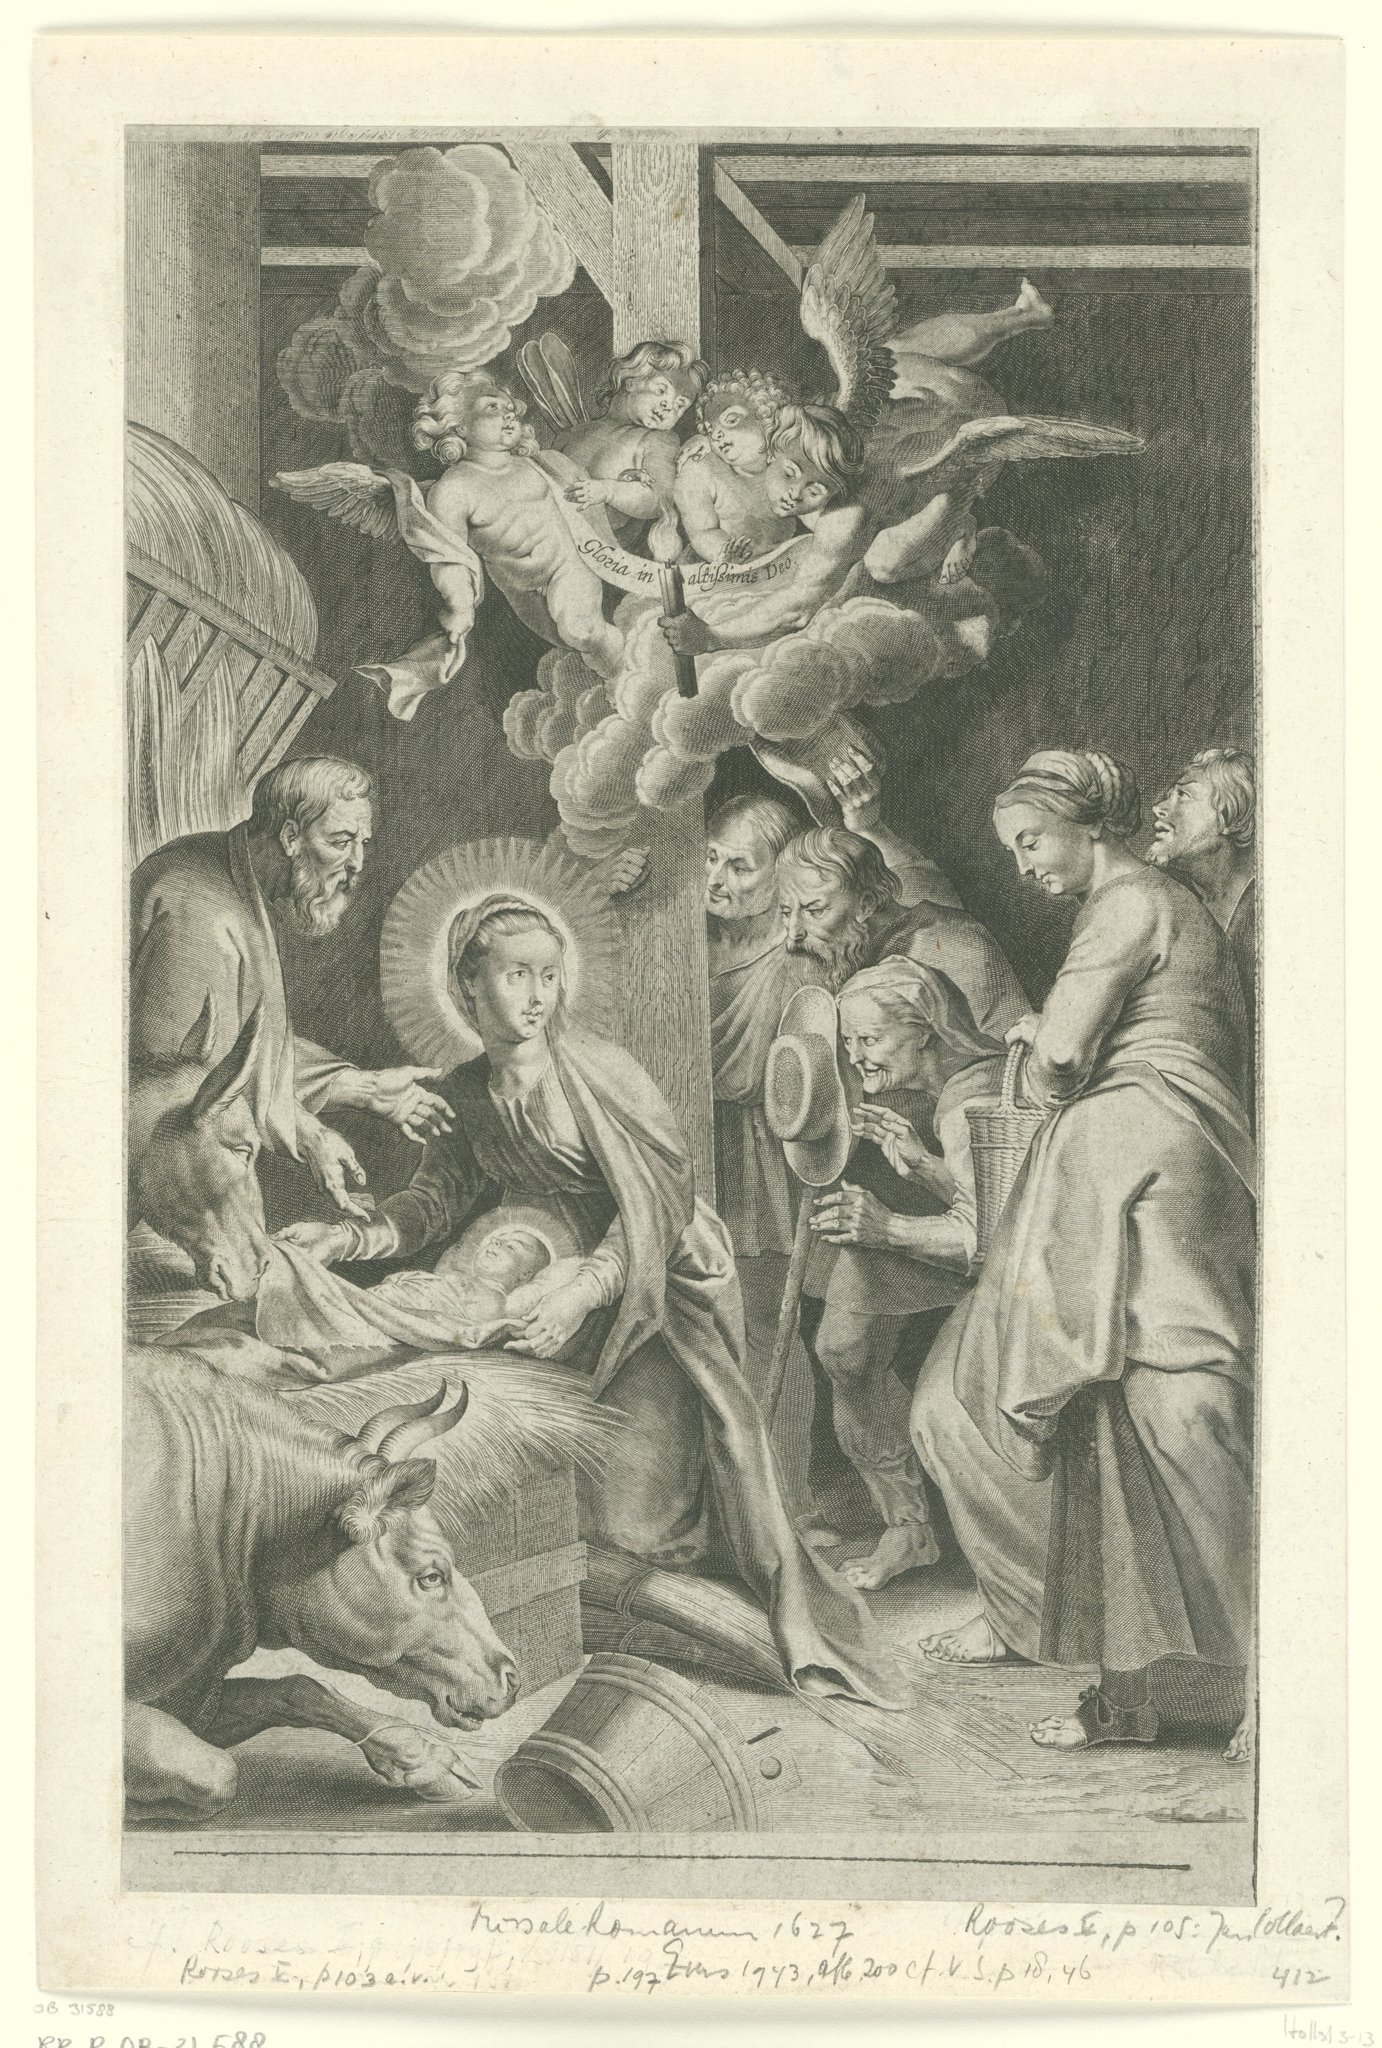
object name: print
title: De aanbidding door de herders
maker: Anonymous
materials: paper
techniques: engraving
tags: adoration of the christ-child by the shepherds; mary and joseph present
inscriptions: collector's mark: Lugt 240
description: Maria, Jozef en het geboren kind in een stal. Linksvoor de os en de ezel. Rechts een groep herders en twee vrouwen die het kind komen aanbidden. Boven hen vier engeltjes met banderol waarop de tekst 'Gloria in altissimis Deo'.